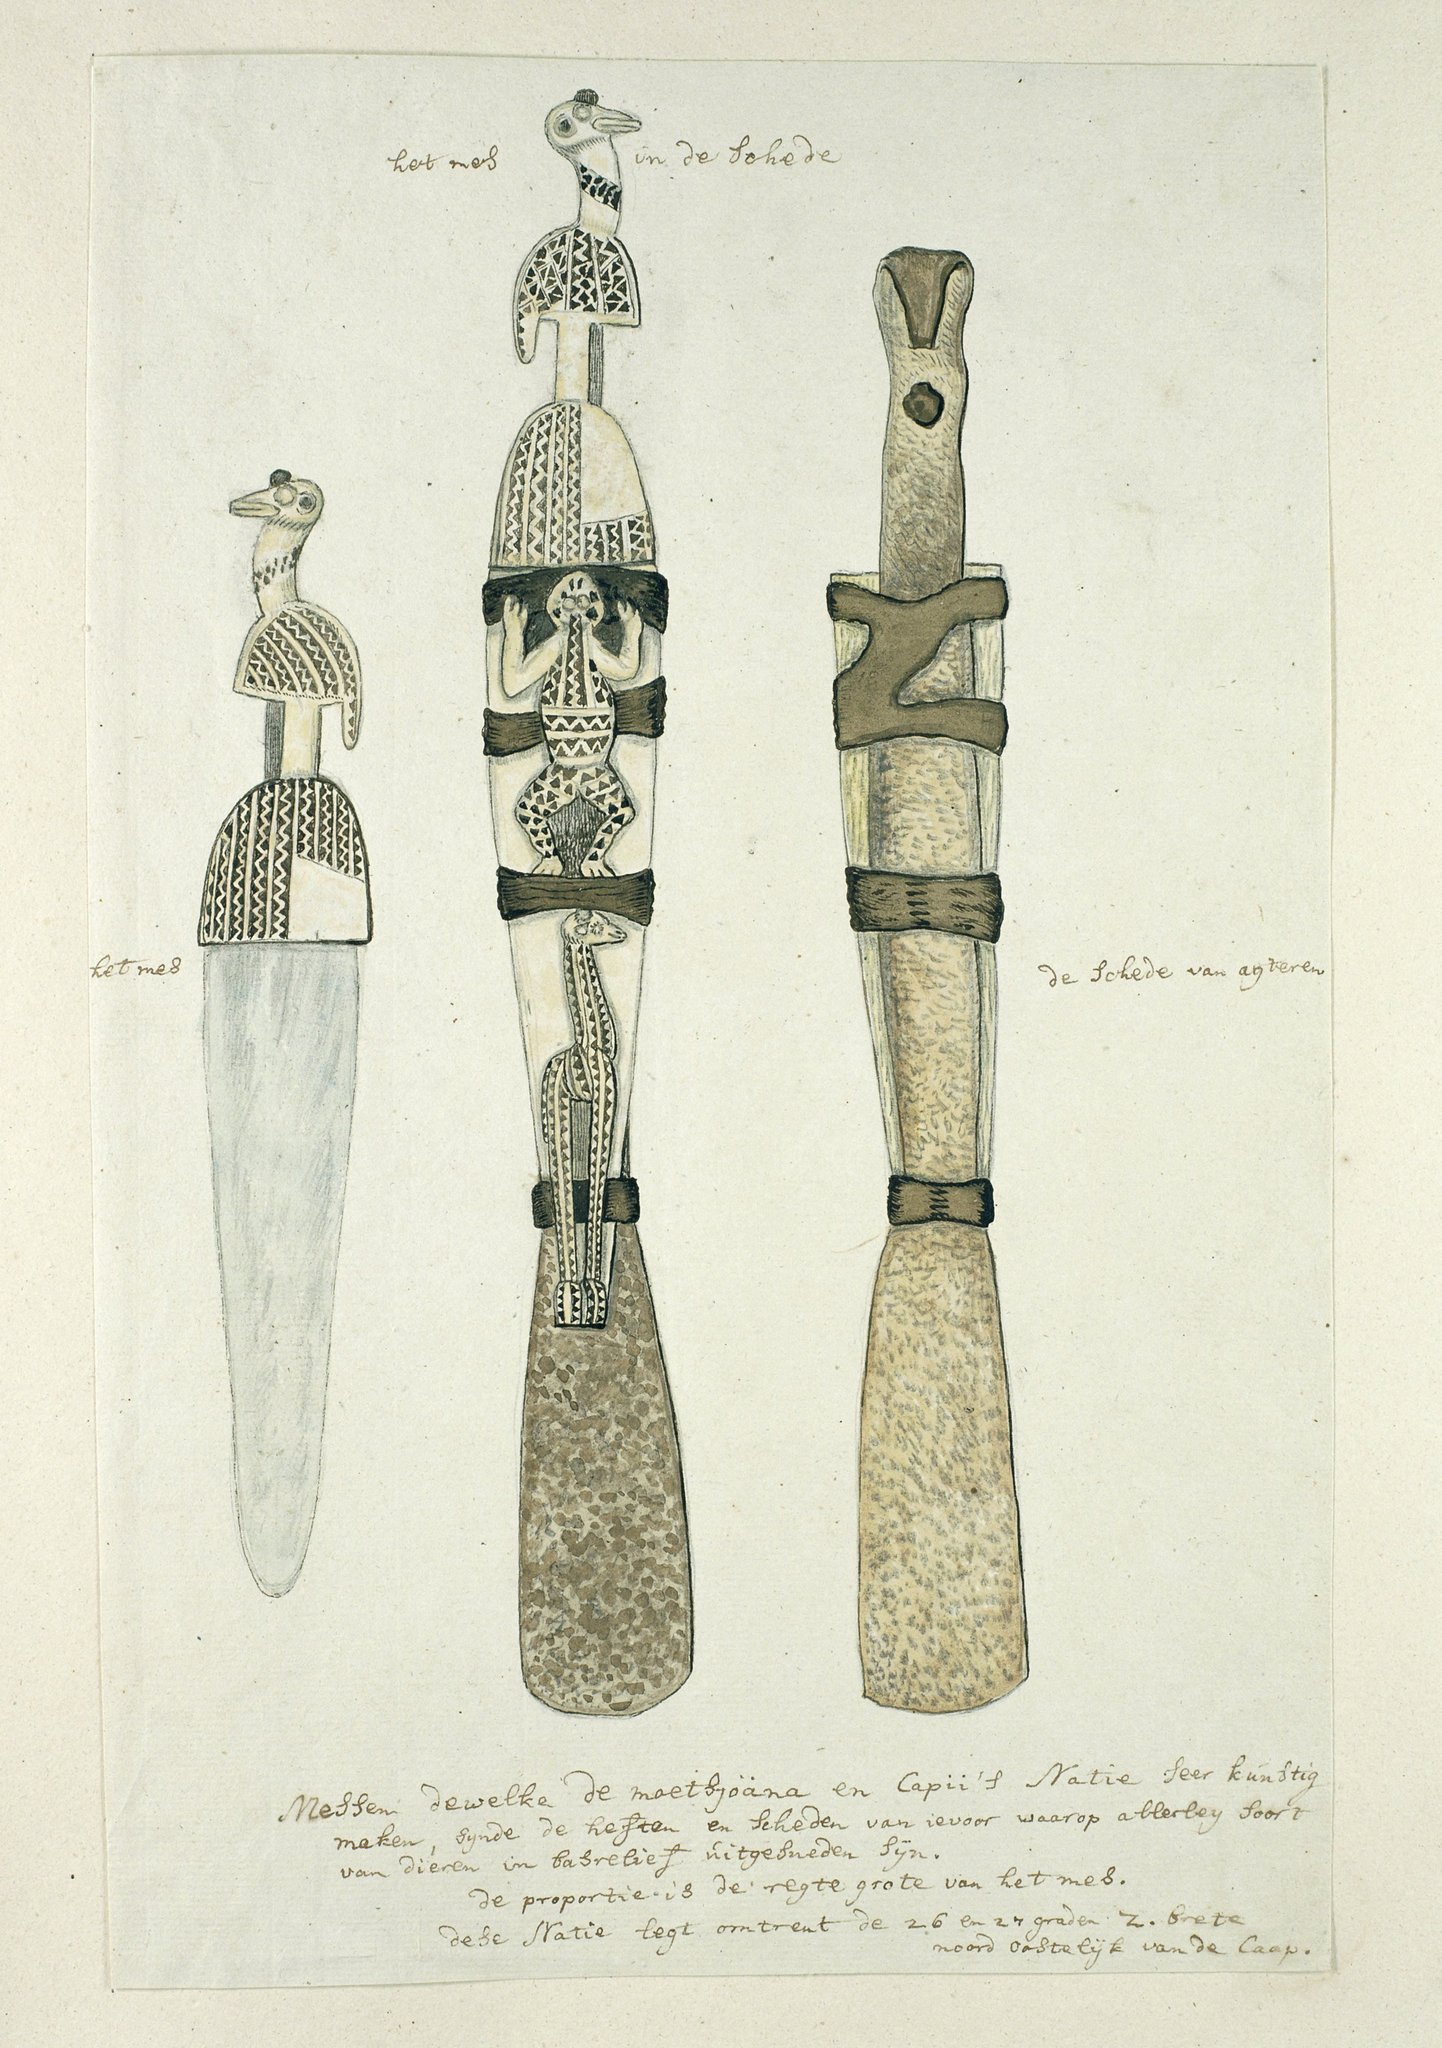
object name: drawing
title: A Tswana or Kora knife with its sheath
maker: robert jacob gordon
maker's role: draughtsman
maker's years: 1743-1795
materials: chalk, ink, paper, pencil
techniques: brush, pen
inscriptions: annotation: ‘m.b.: het mes in de Schede (aan weerszijden van het mes); links: het mes; rechts: de Schede van agteren; onderaan: Messen dewelke de Moetsjoana en Capii's Natie Seer kunstig / maken, Sijnde de heften en Scheden van ievoor waarop allerley Soort / van dieren in basreleif uitgesneden Sijn. / de proportie is de regte grote van het mes. / dese Natie legt omtrent de 26 en 27 (24?) Z.brete / noord oostelijk van de Caap.’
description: Drie afbeeldingen van een mes met schede, van voren en achteren gezien, vervaardigd door de Moetjoanaas en de Capii.